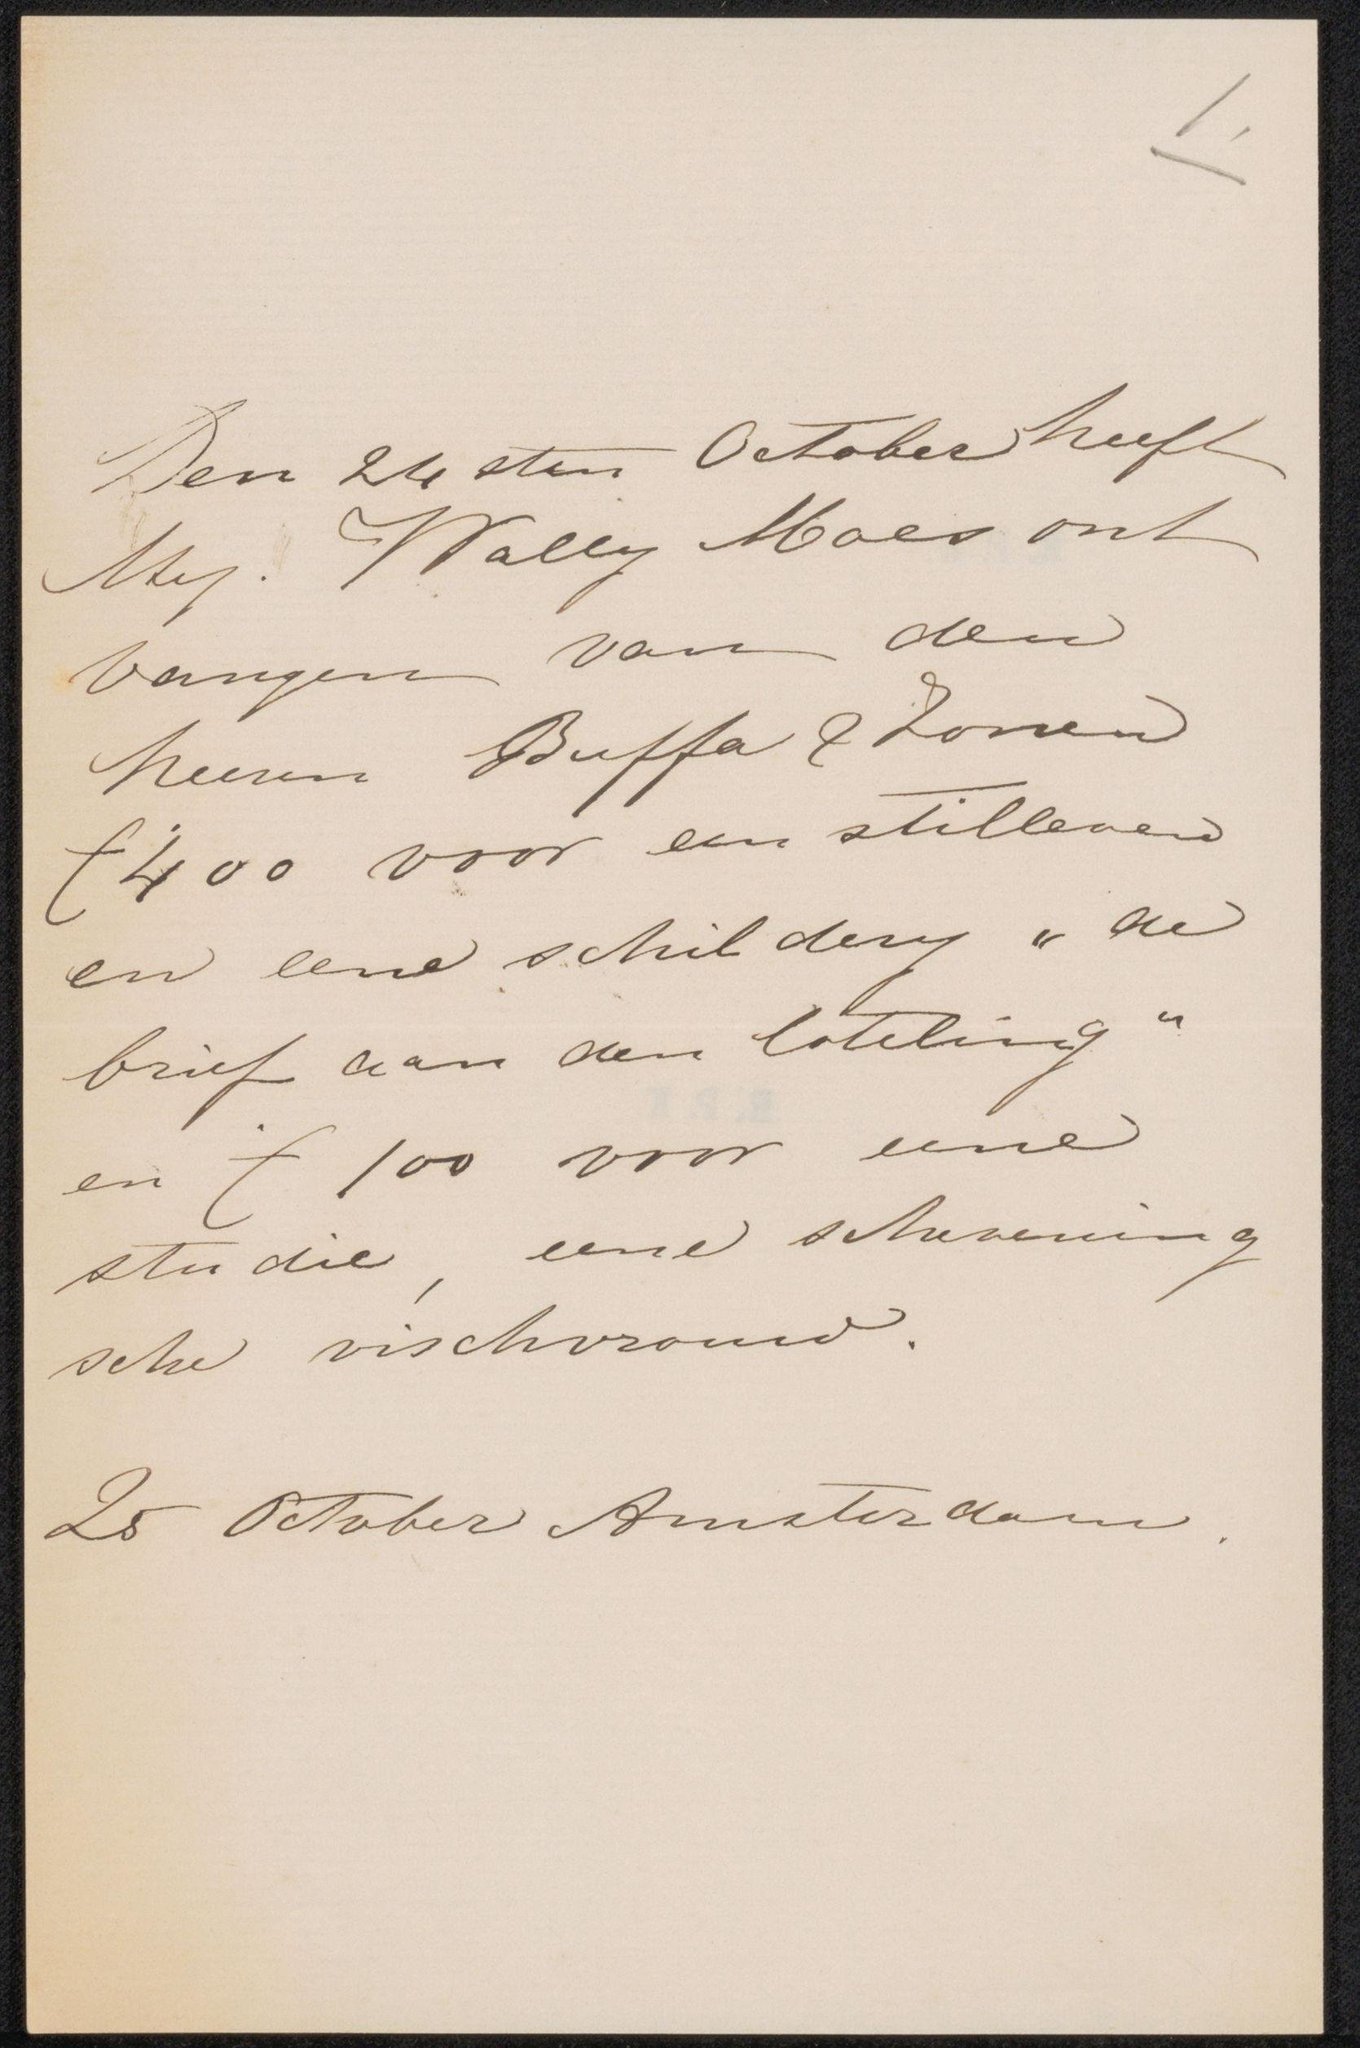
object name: ontvangstbewijs, kwitantie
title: Kwitantie voor Frans Buffa en Zonen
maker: wally moes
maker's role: draughtsman, print maker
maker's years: 1856-1918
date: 1866-1918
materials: ink, paper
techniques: pen, writing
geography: amsterdam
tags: publisher, painting (including book-illumination, miniature-painting), money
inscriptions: collector's mark: Lugt 2233